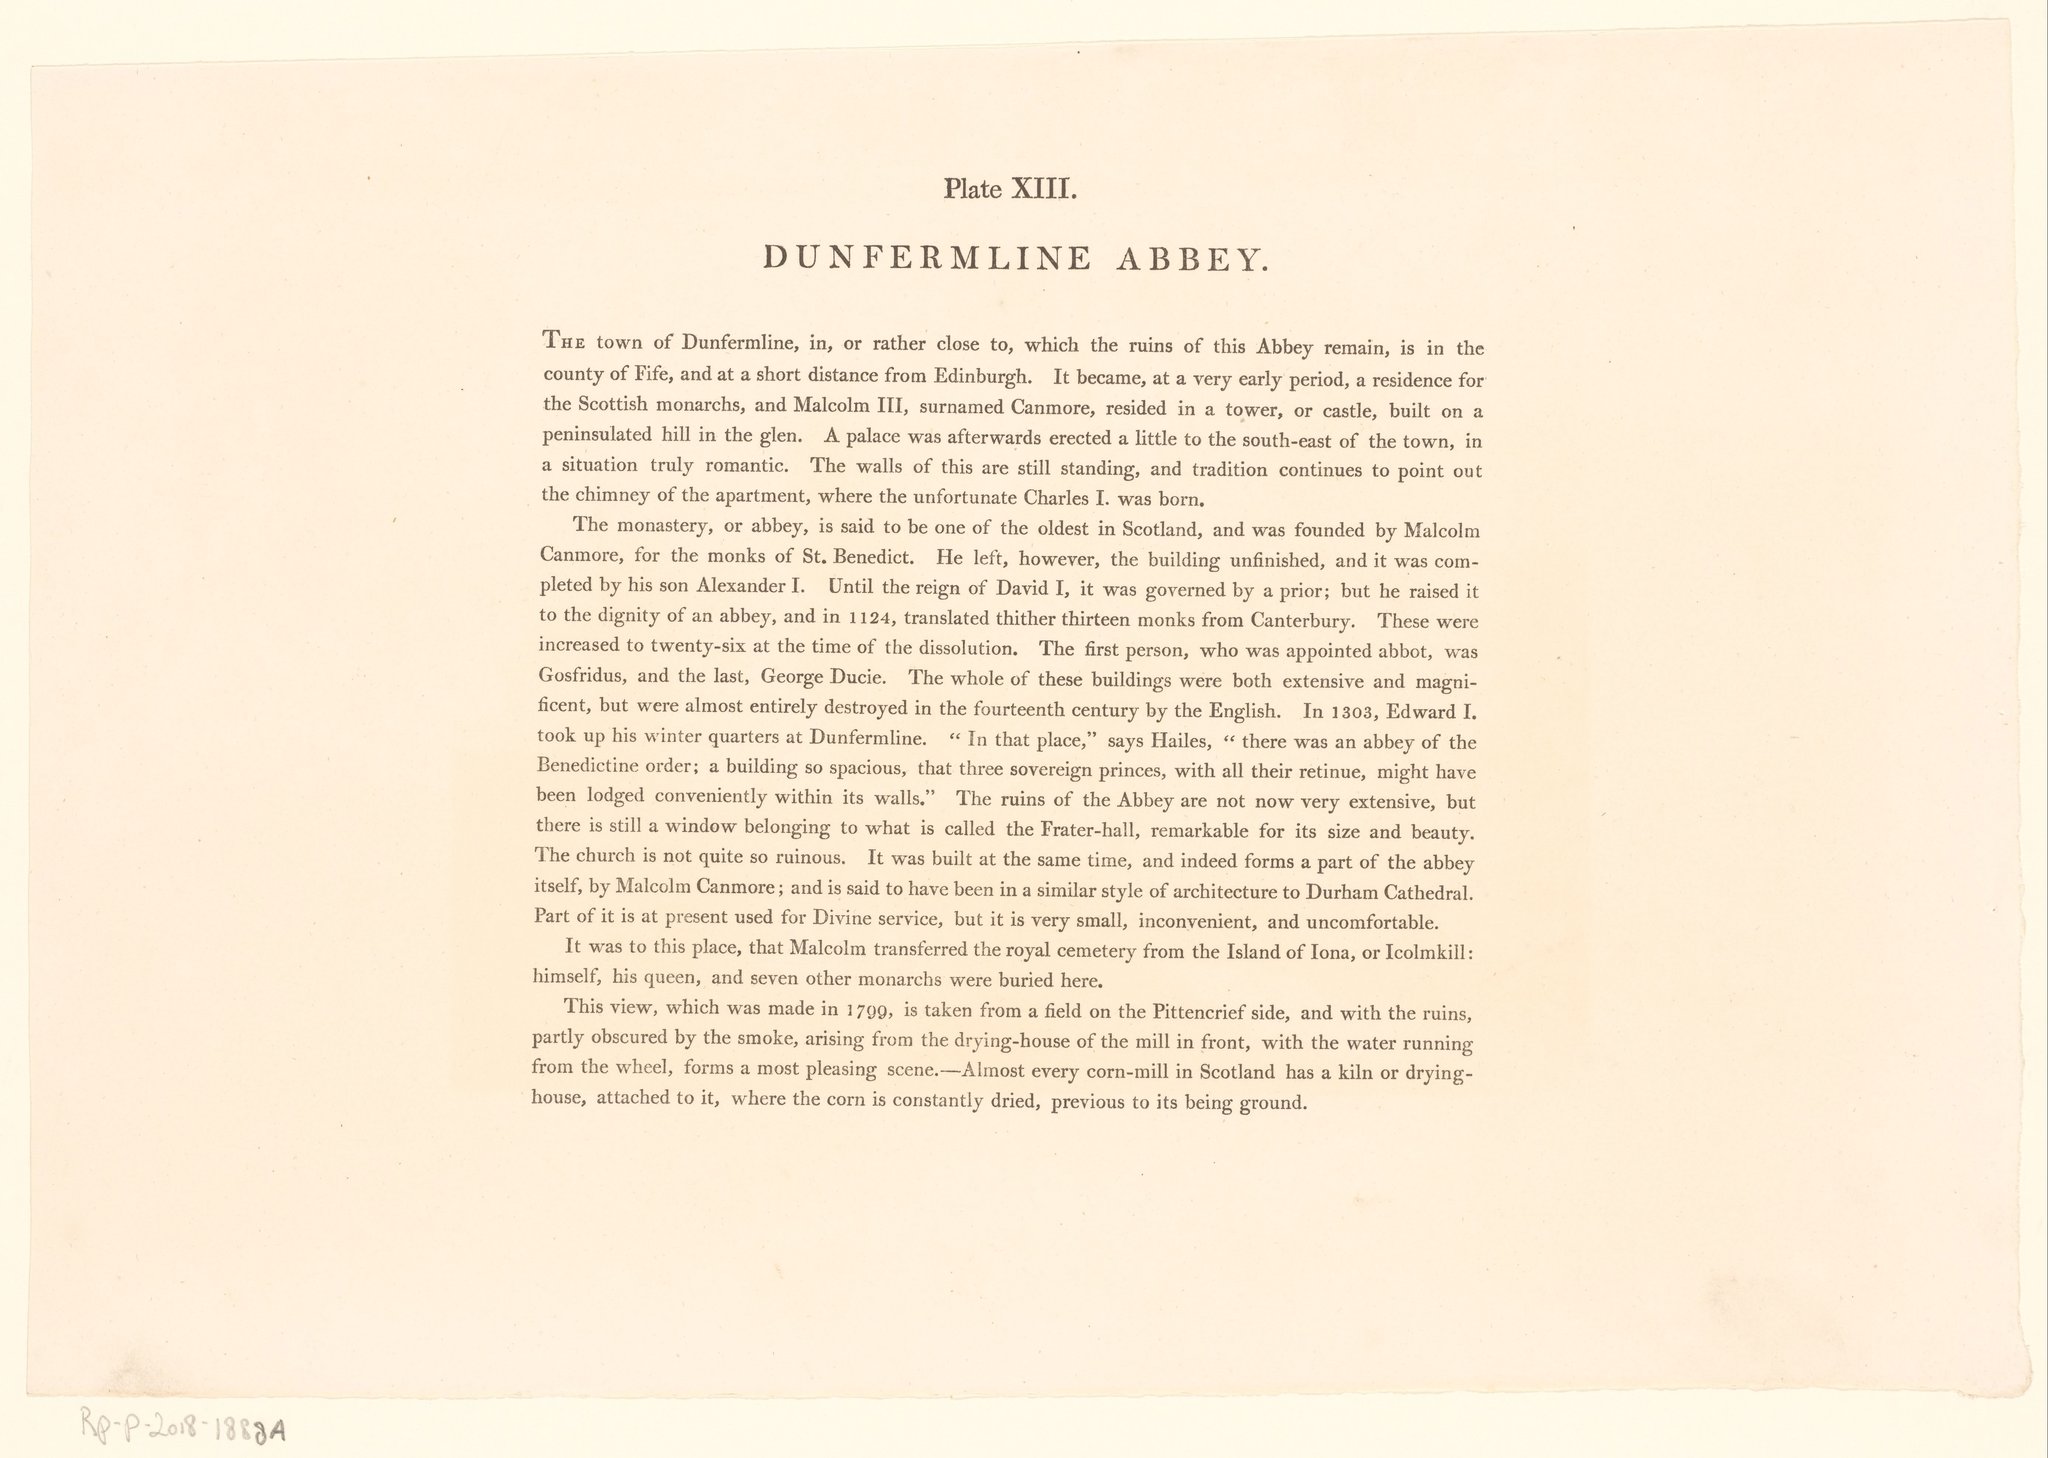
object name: text sheet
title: Tekstblad bij een prent van Dunfermline Abbey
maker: william miller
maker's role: bookseller, printer, publisher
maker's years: 1769-1844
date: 1801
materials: paper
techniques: letterpress printing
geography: london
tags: dunfermline abbey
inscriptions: collector's mark: Lugt 2228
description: Tekstblad gebruikt in: Scotia Depicta; or the antiquities, castles, public buildings, noblemen (...). Londen: William Miller, 1801.